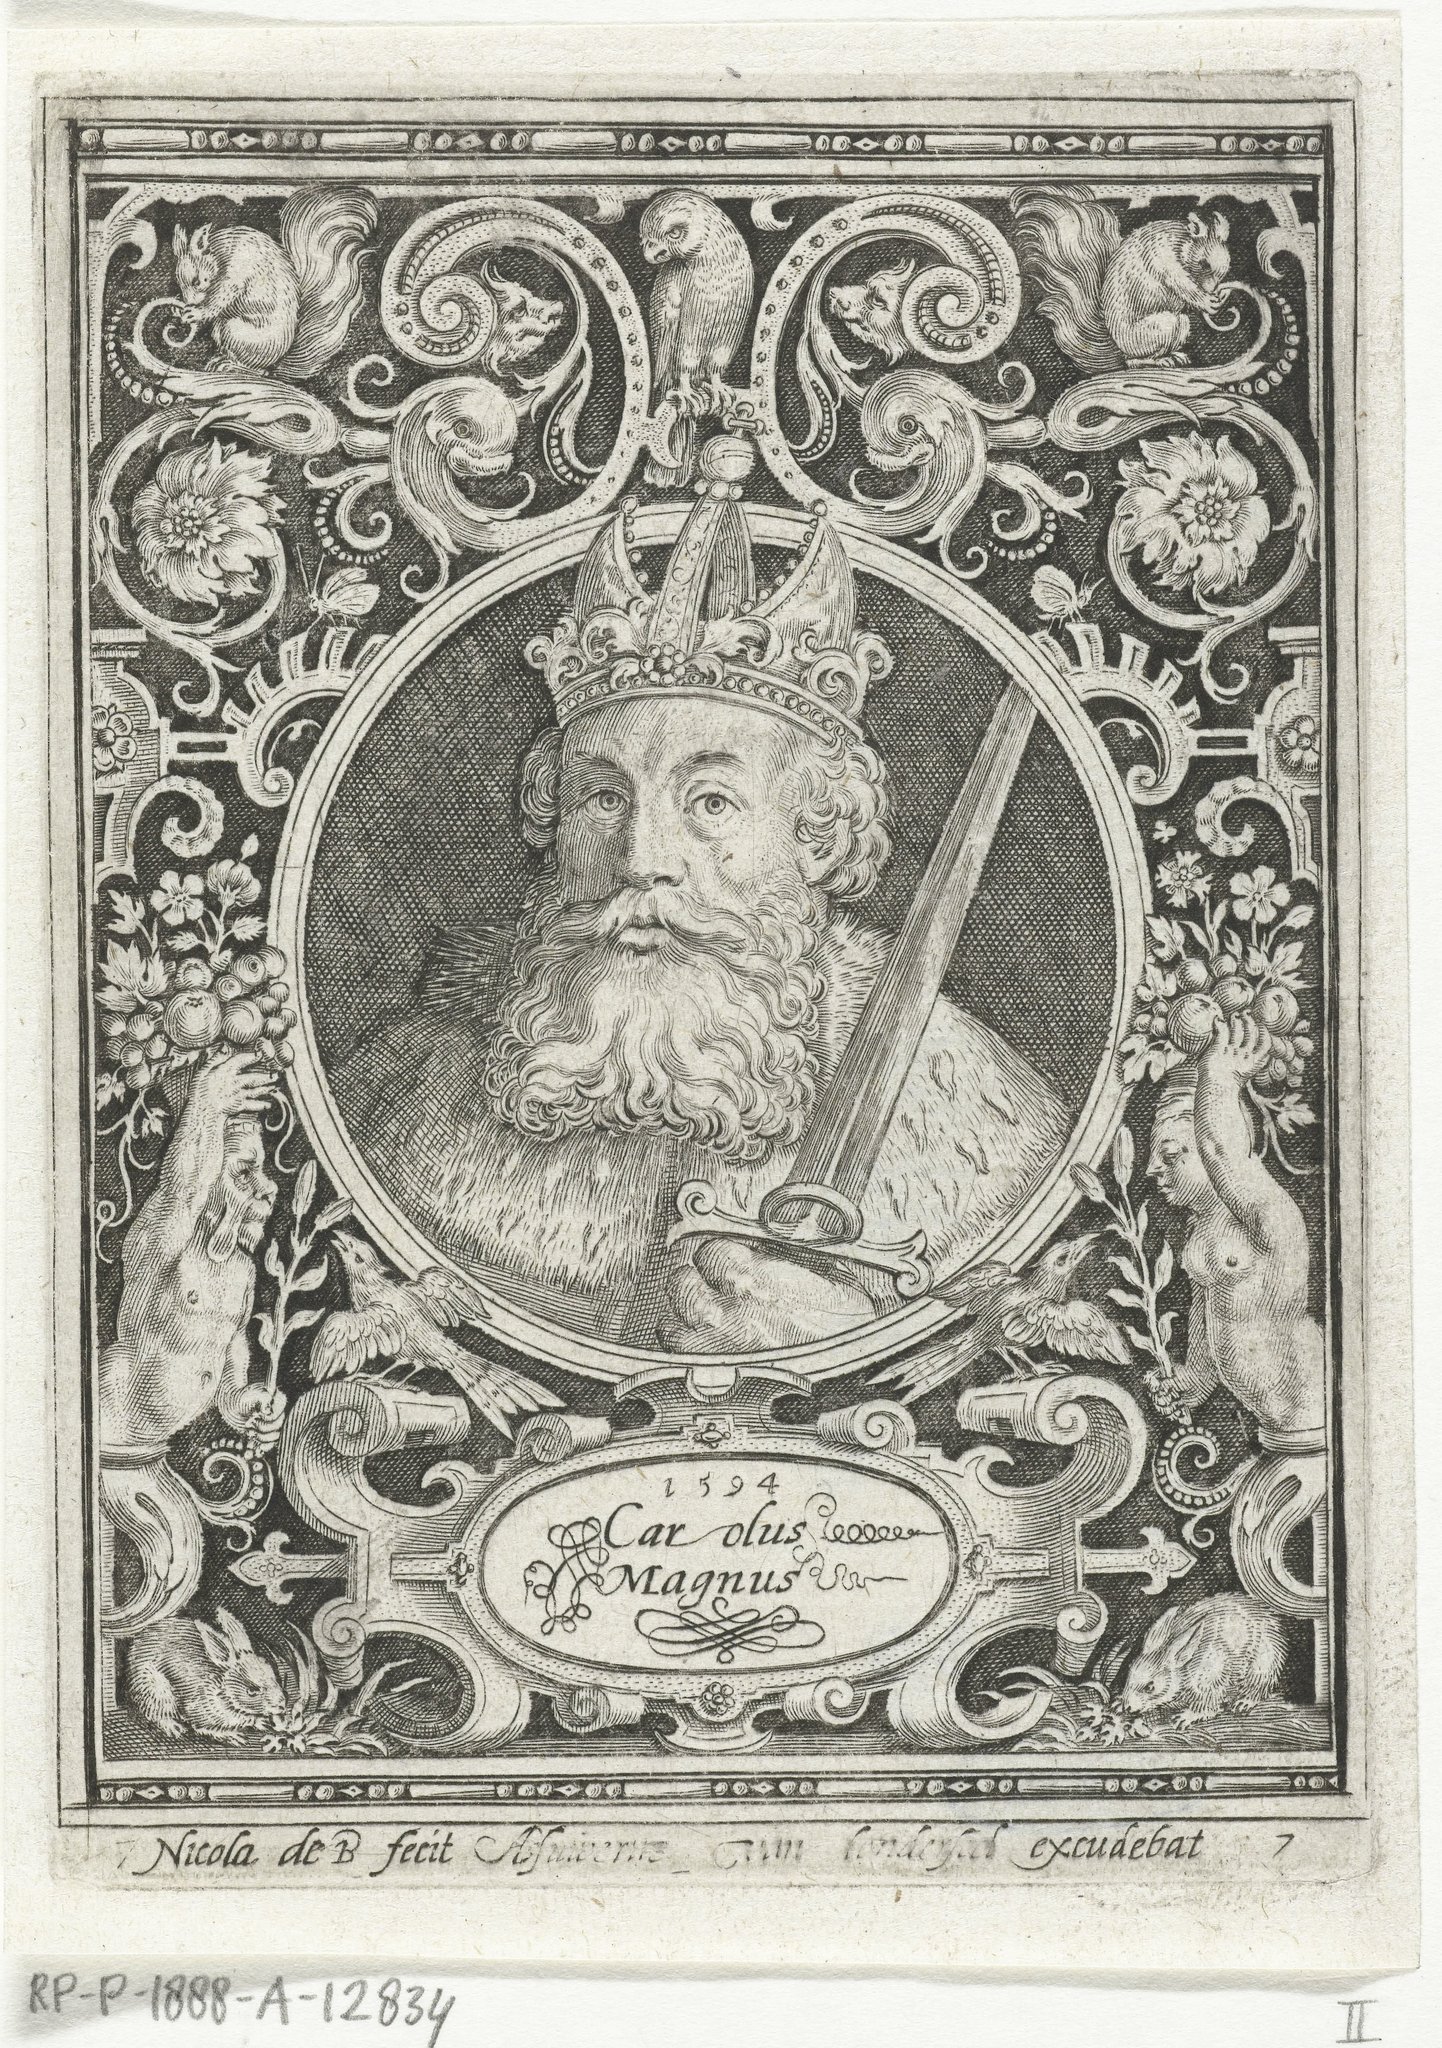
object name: print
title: Portret van Karel de Grote in medaillon binnen rechthoekige omlijsting met ornamenten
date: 1594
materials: paper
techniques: engraving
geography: netherlands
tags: charlemagne (holy roman emperor), charlemagne (one of the nine worthies)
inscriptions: collector's mark: Lugt 2228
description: Prent uit serie van negen prenten met de negen besten. De naam van de uitgever Assuerus van Londerseel die staat vermeld op de eerste staat is hier slechts gedeeltelijk verwijderd.